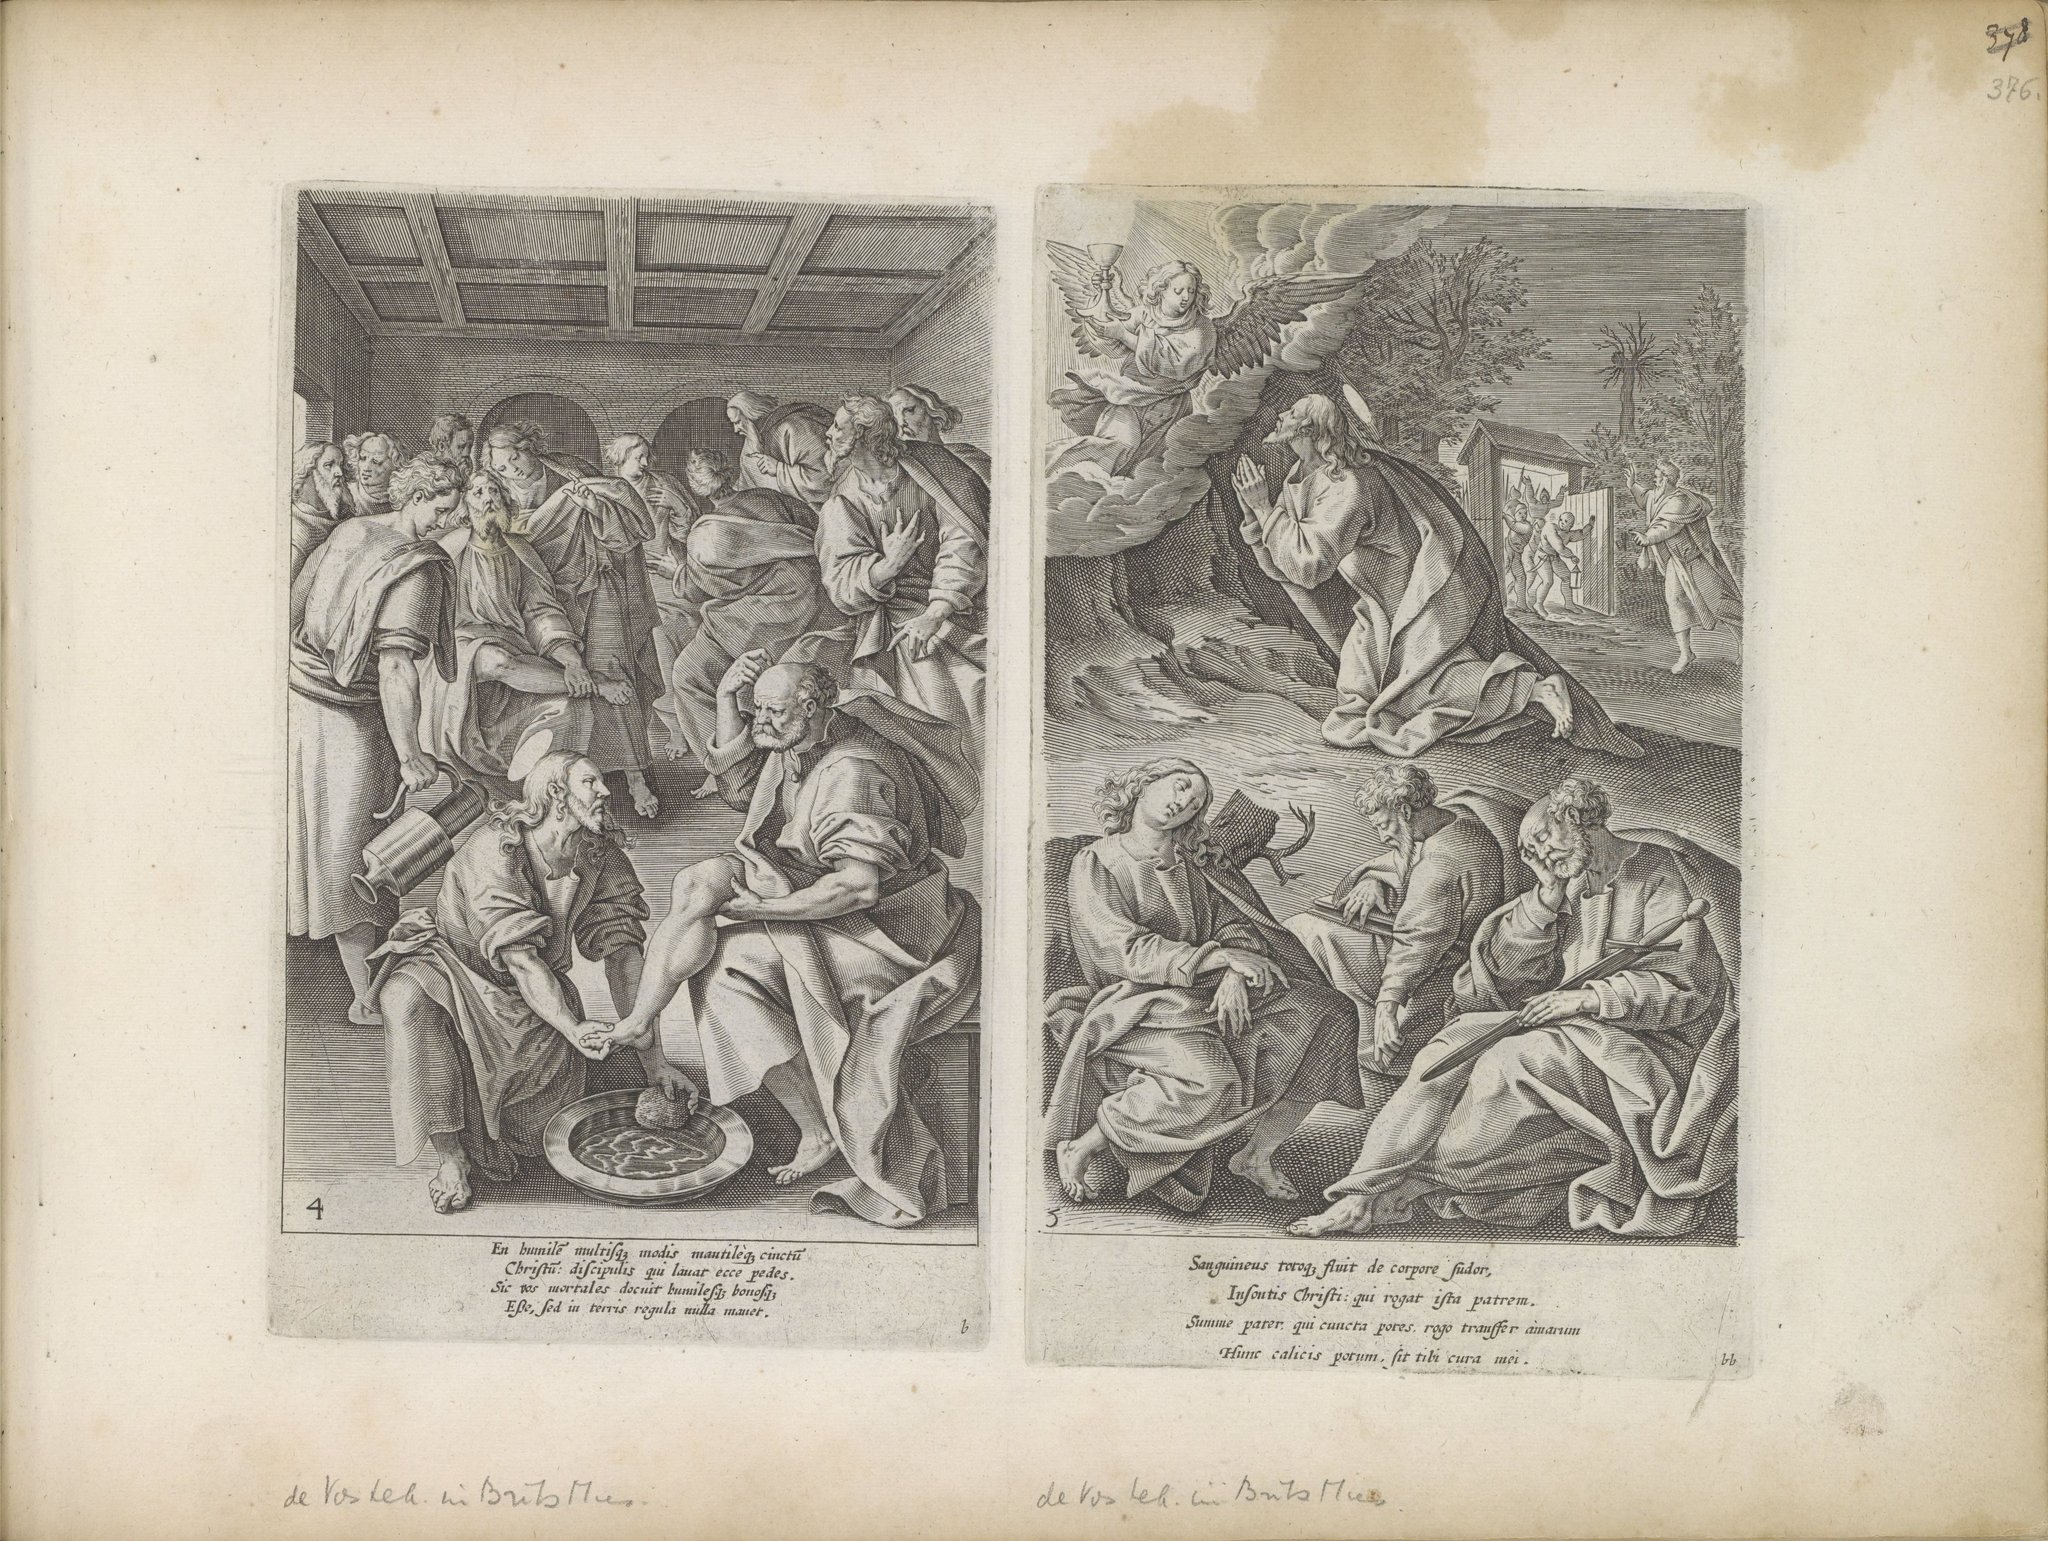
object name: album leaf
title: Theatrum Biblicum Hoc Est Historiae Sacrae Veteris et Novi Testamenti Tabulis Aeneis Expressae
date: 1585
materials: paper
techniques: engraving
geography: amsterdam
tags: christ washes peter's feet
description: Christus zit geknield voor de apostel Petrus en wast zijn voeten. Petrus protesteert. De andere apostelen staan blootvoets in het vertrek. Onder de voorstelling een vierregelig vers in het Latijn. Rechtsonder de letter: b. Deze prent maakt deel uit van een album.